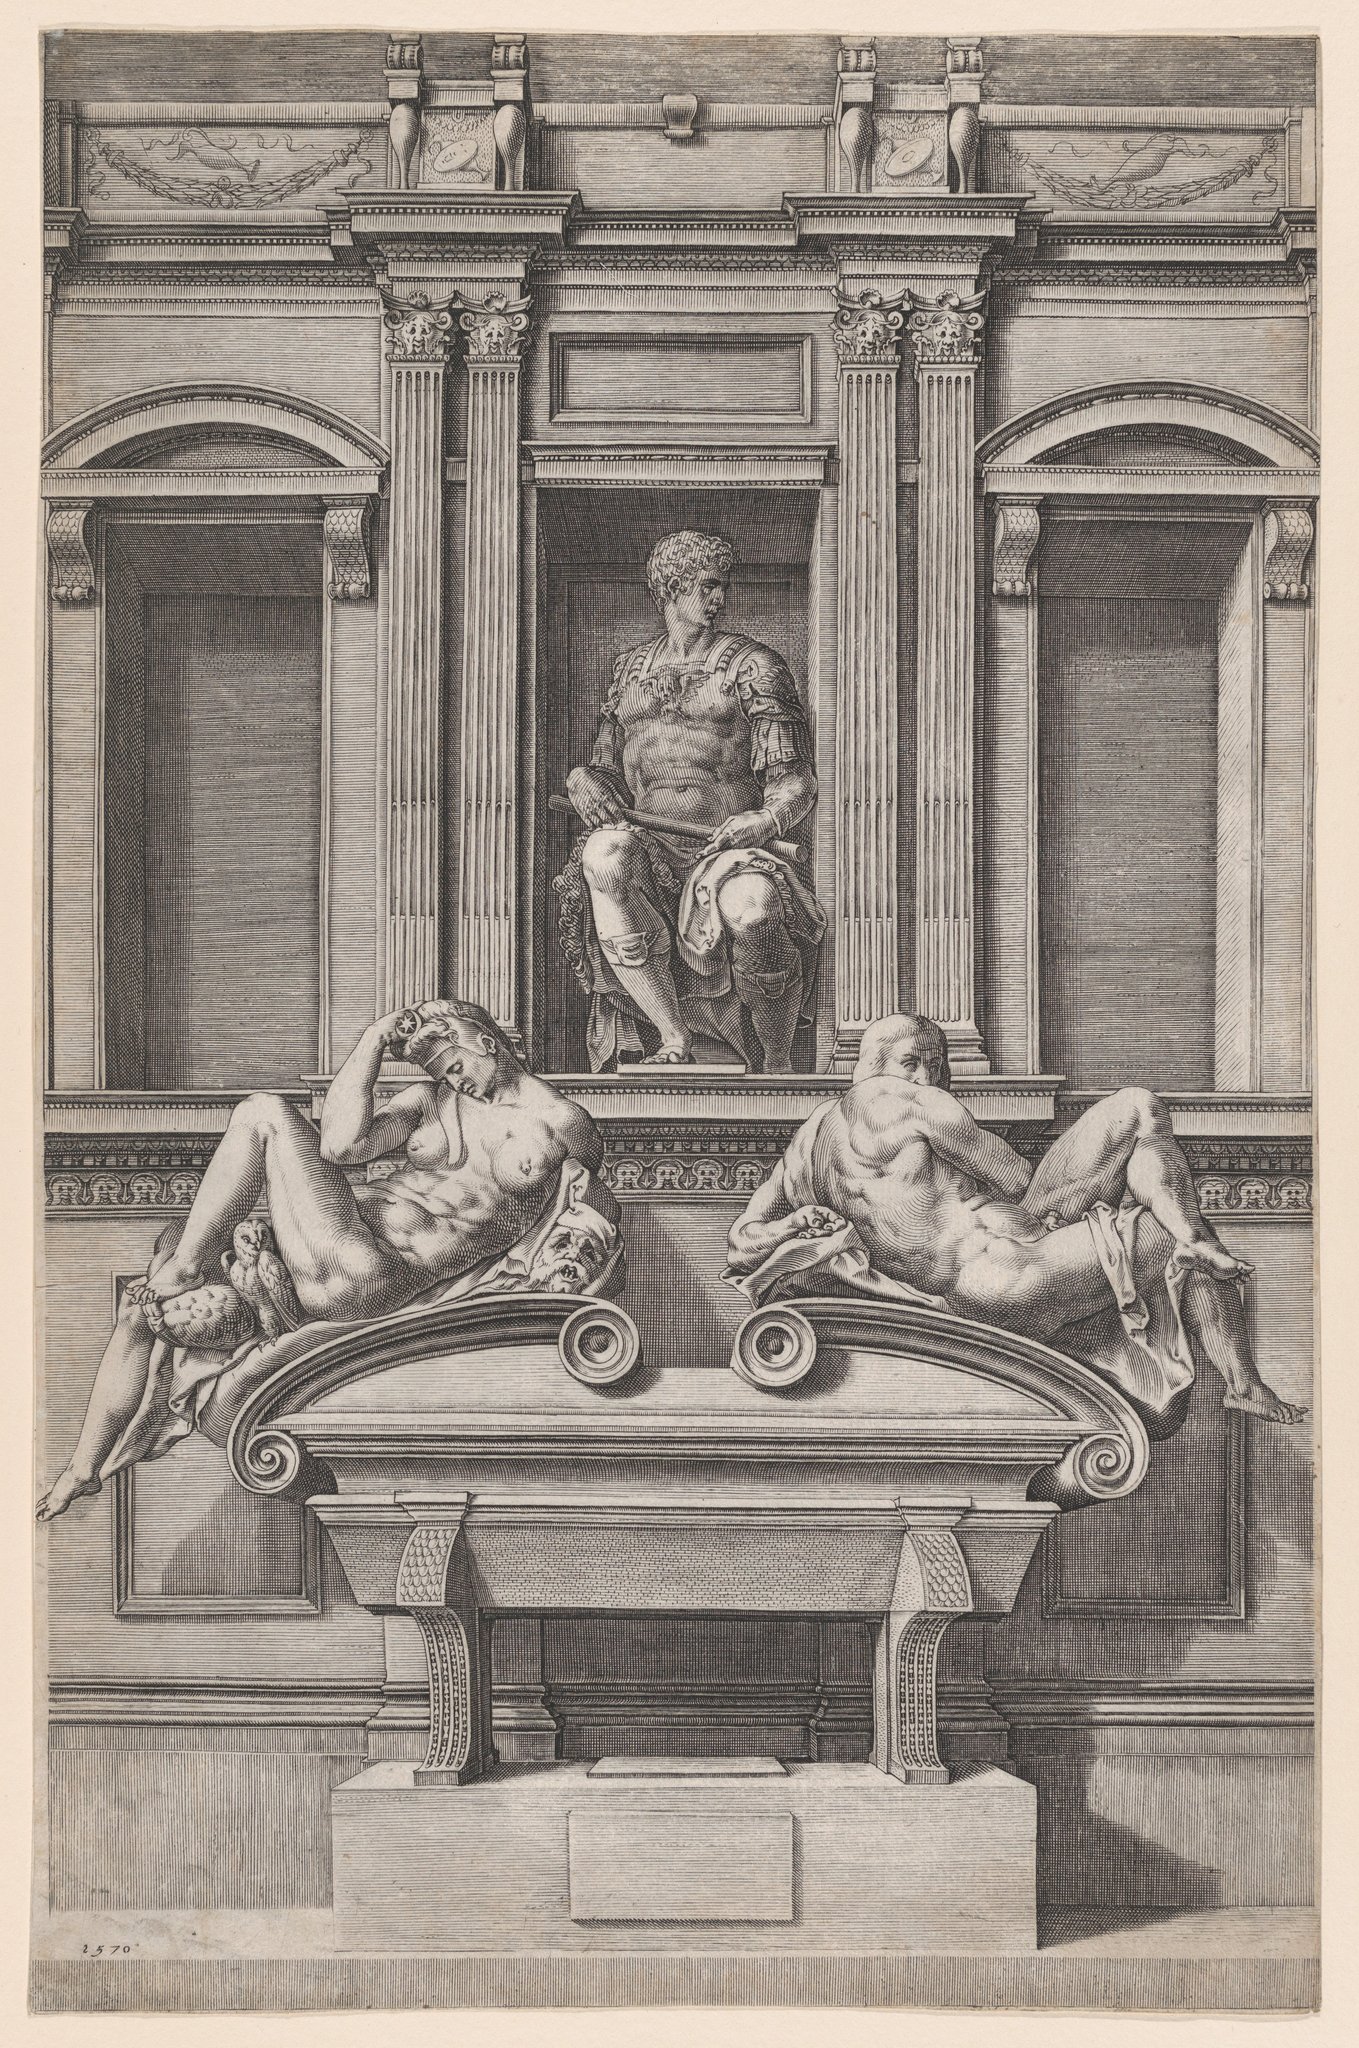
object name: print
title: The Tomb of Giuliano de' Medici from The Tombs of the Medici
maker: cornelis cort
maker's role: artist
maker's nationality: netherlandish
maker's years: 1533-1578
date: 1570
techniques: engraving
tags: tombs,men,male nudes,female nudes